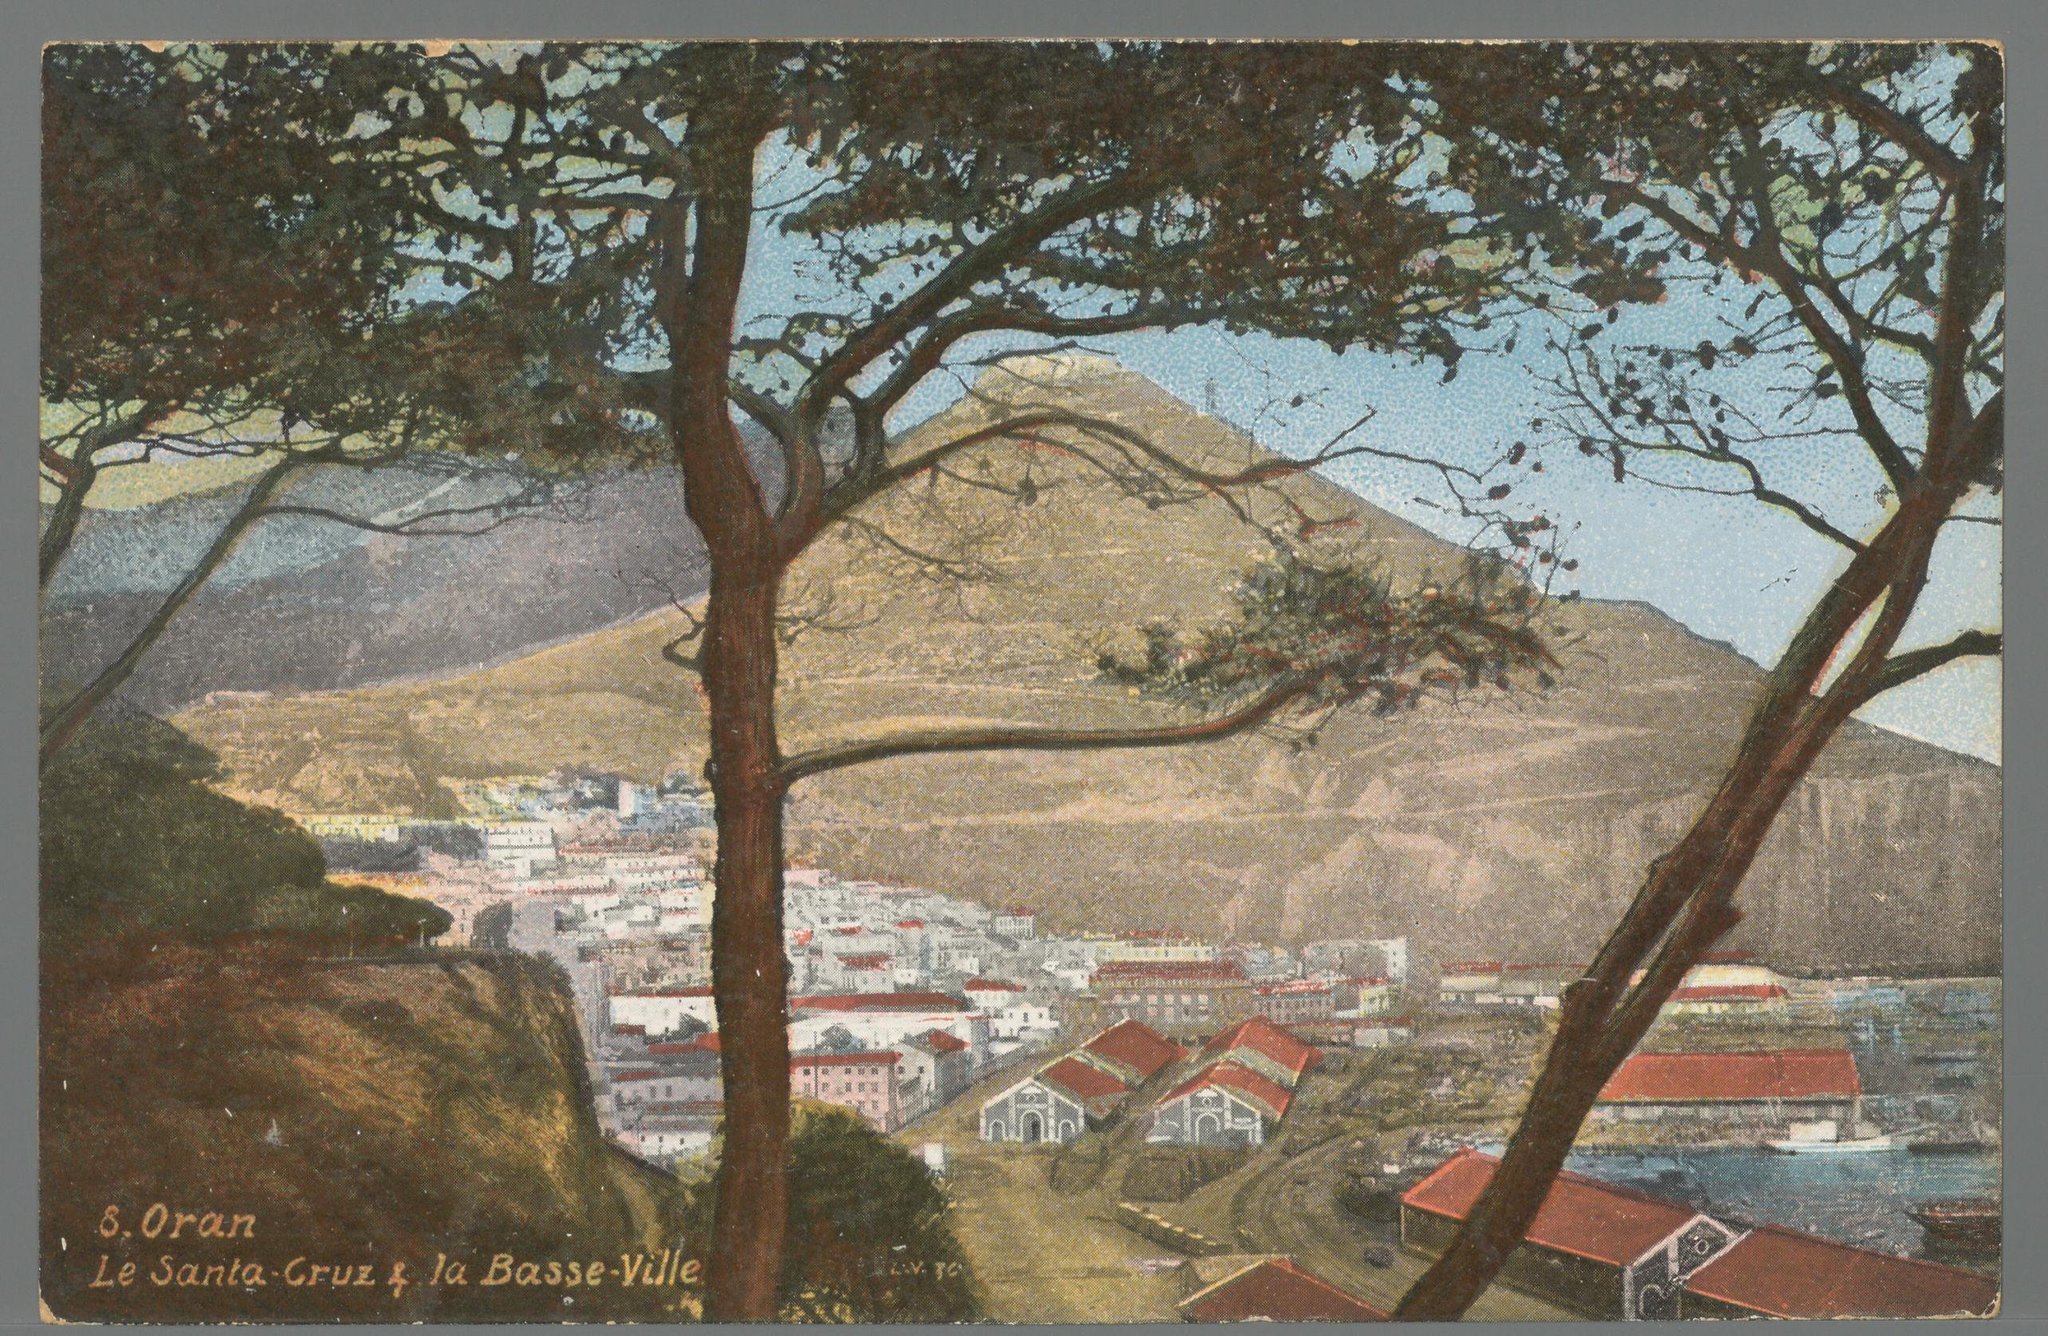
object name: ansichtkaart, prentbriefkaart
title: Oran. Le Santa-Cruz & la Basse-Ville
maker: Anonymous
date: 1903-1905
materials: cardboard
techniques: lithograph, writing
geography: oran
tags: prospect of city, town panorama, silhouette of city, mountains (in tropical and sub-tropical regions)